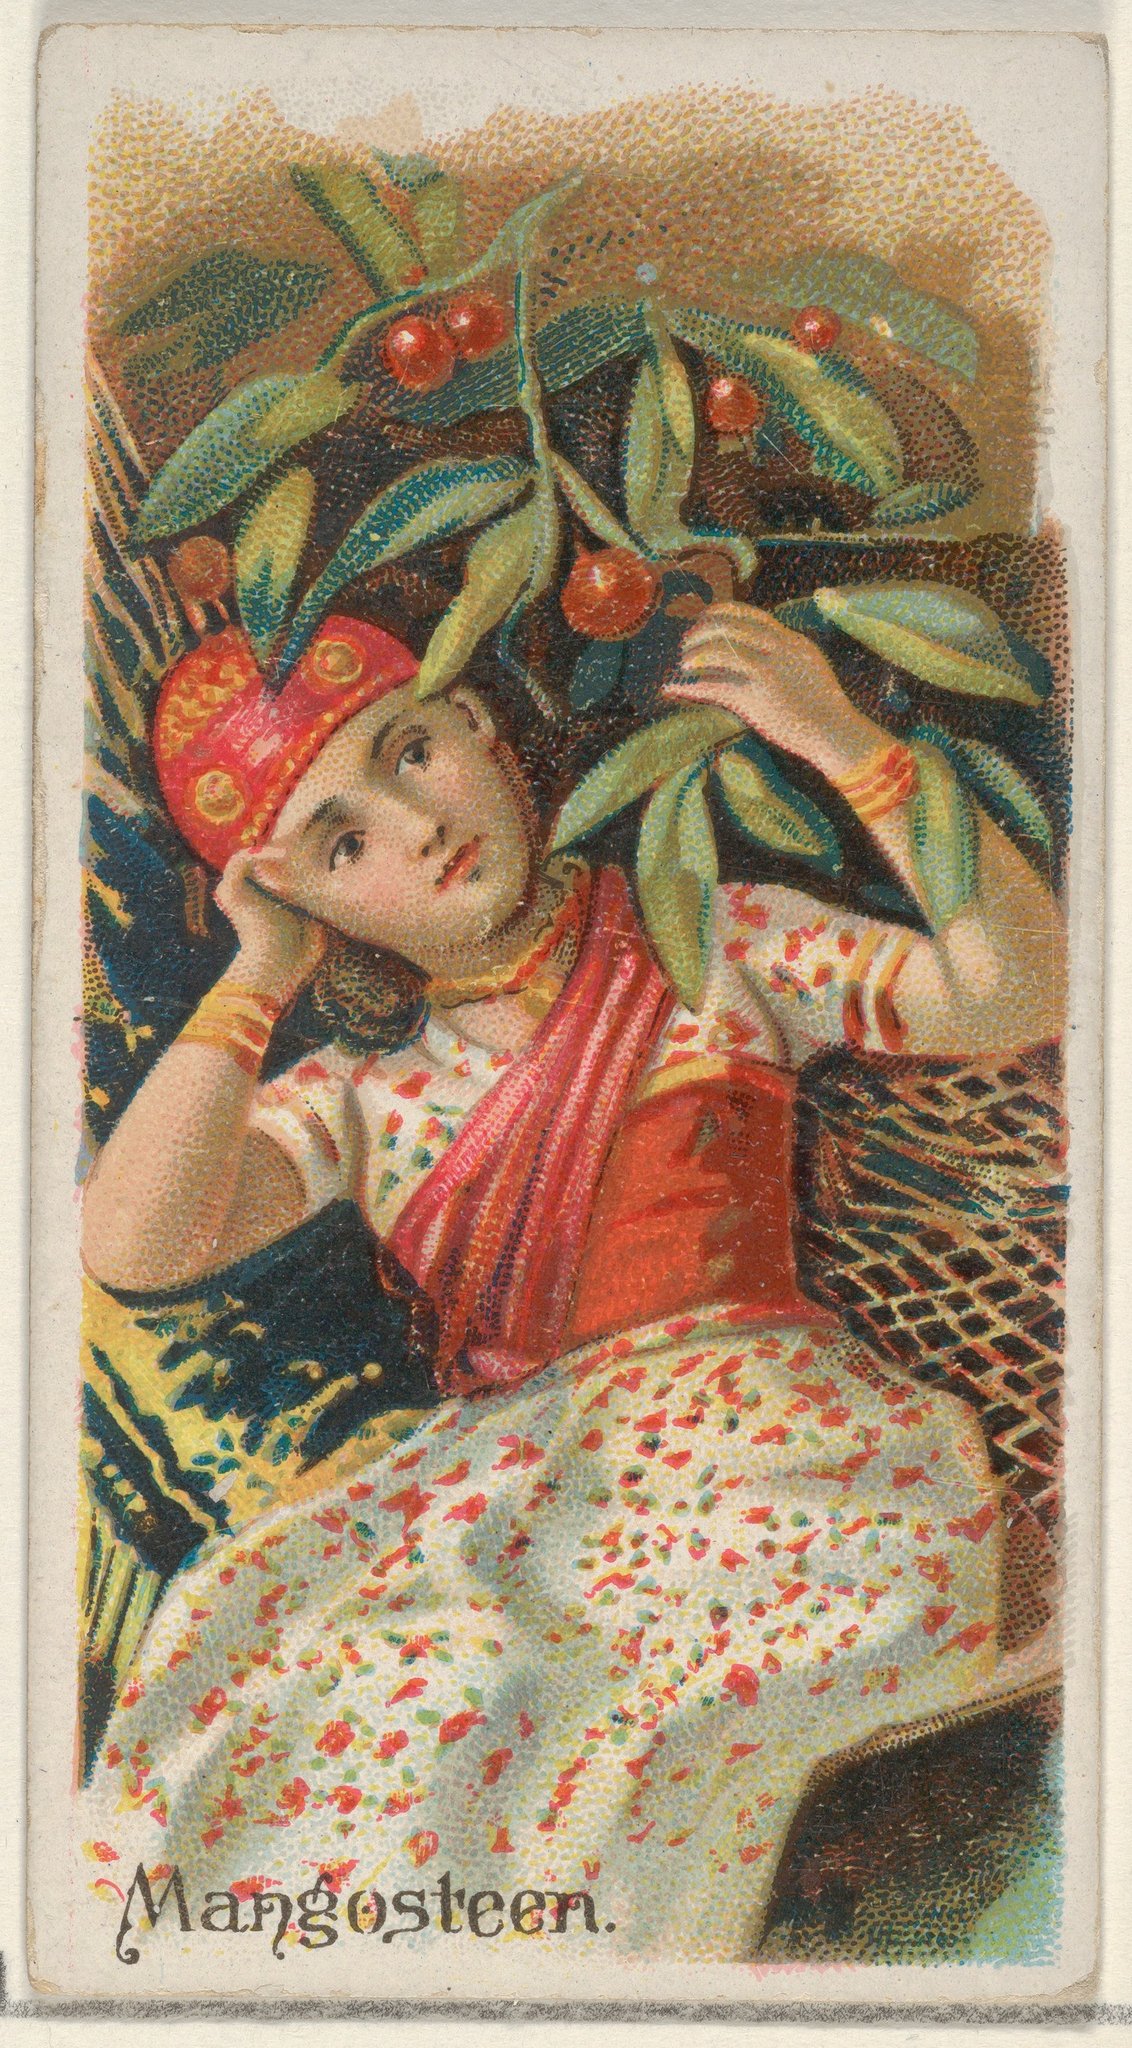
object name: print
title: Mangosteen, from the Fruits series (N12) for Allen & Ginter Cigarettes Brands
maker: allen & ginter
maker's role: publisher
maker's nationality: american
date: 1891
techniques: color lithograph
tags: fruit,women